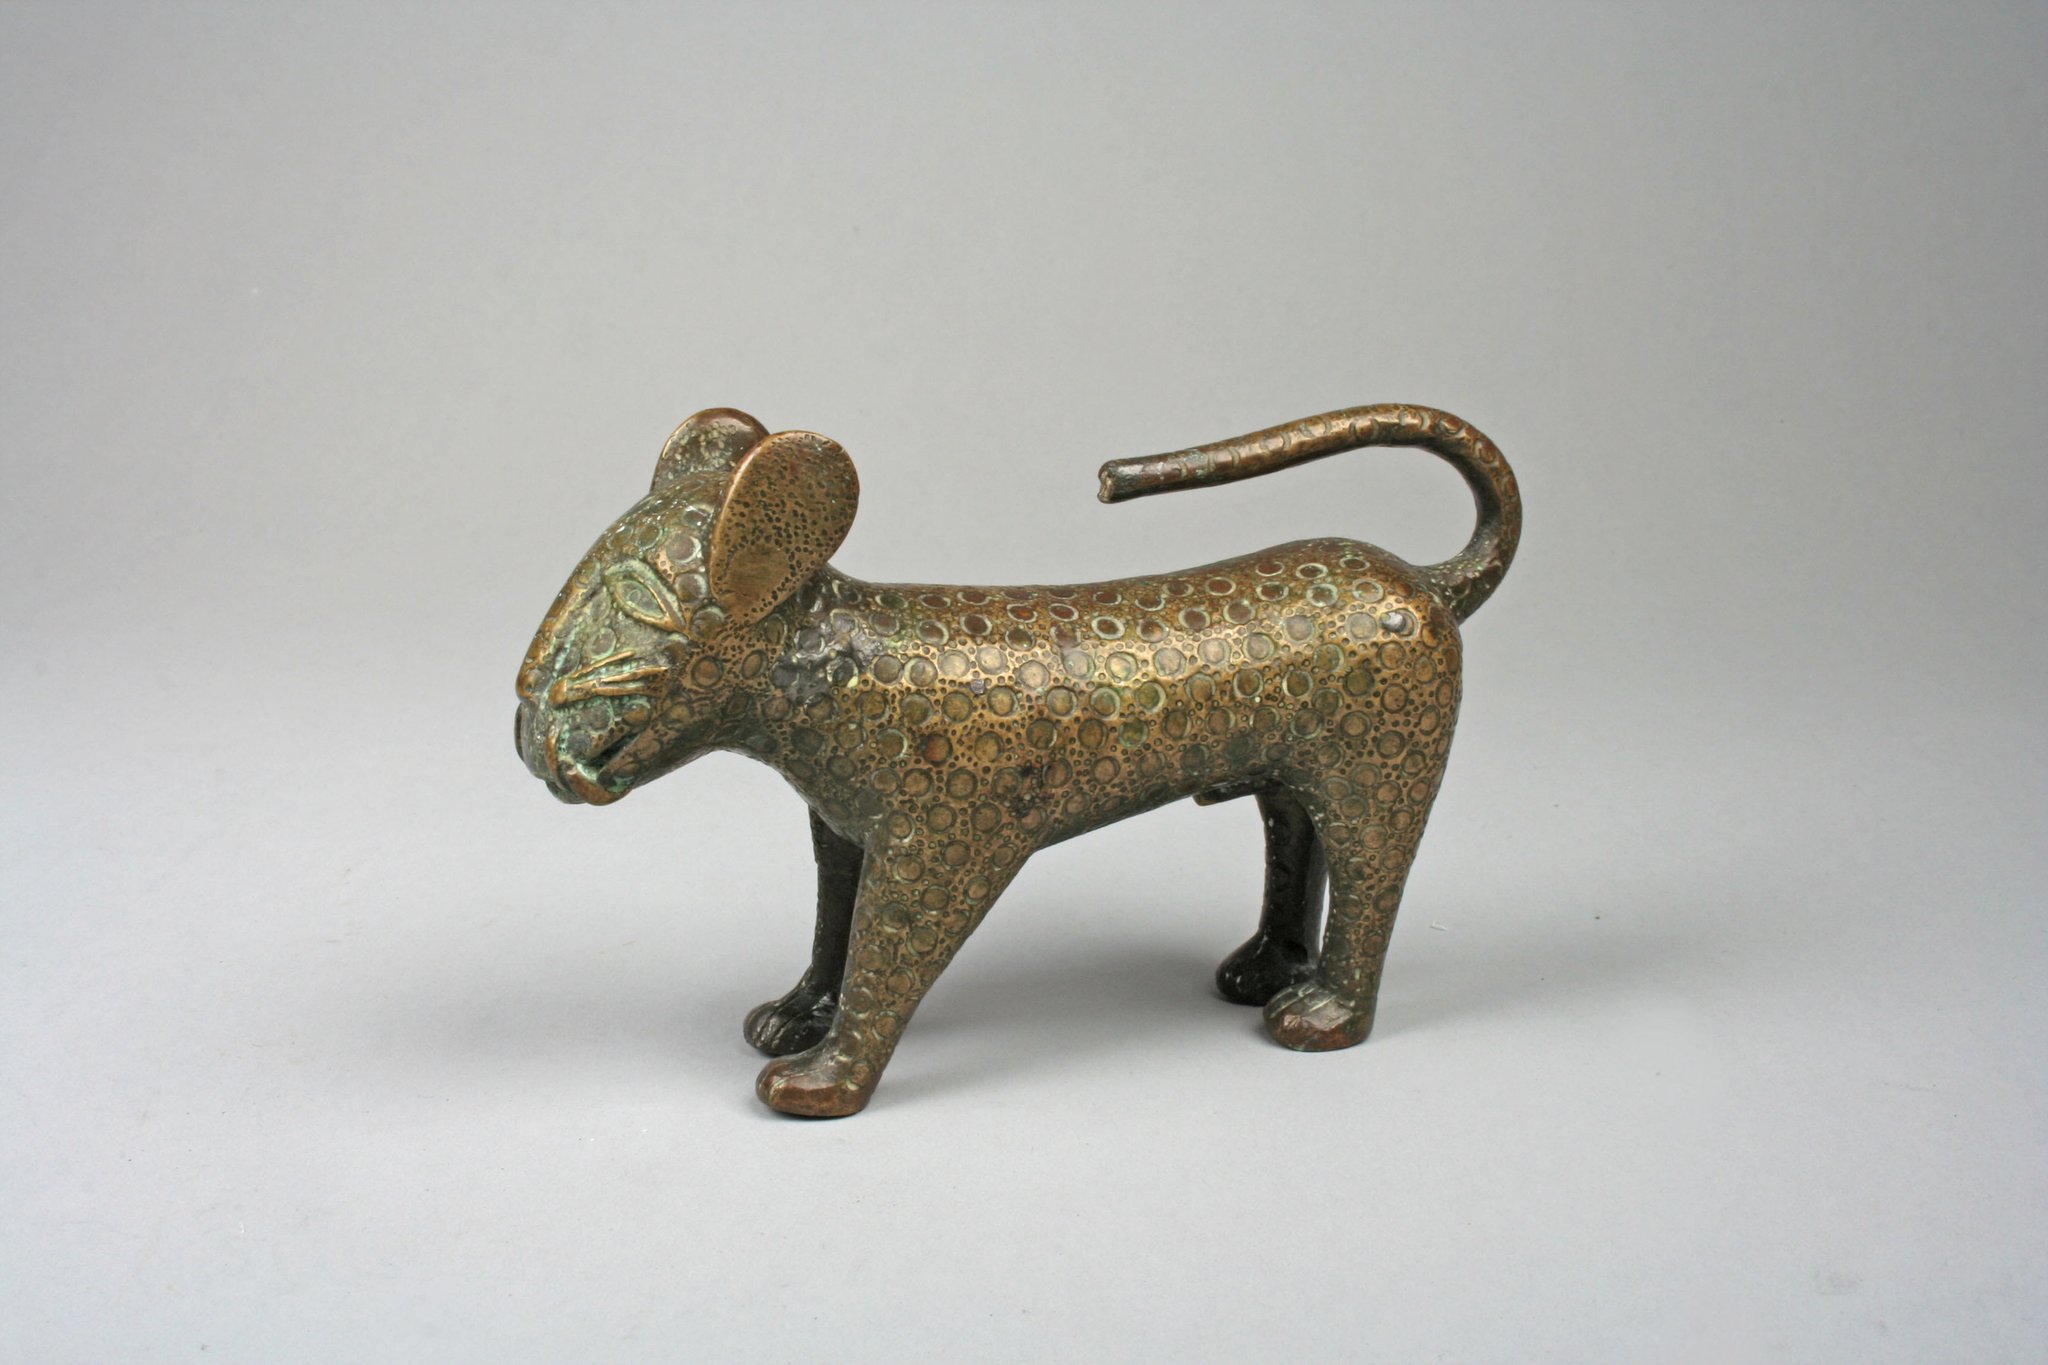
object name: aquamanile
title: Leopard Aquamanile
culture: edo period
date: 1501-1900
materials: brass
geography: nigeria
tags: leopards